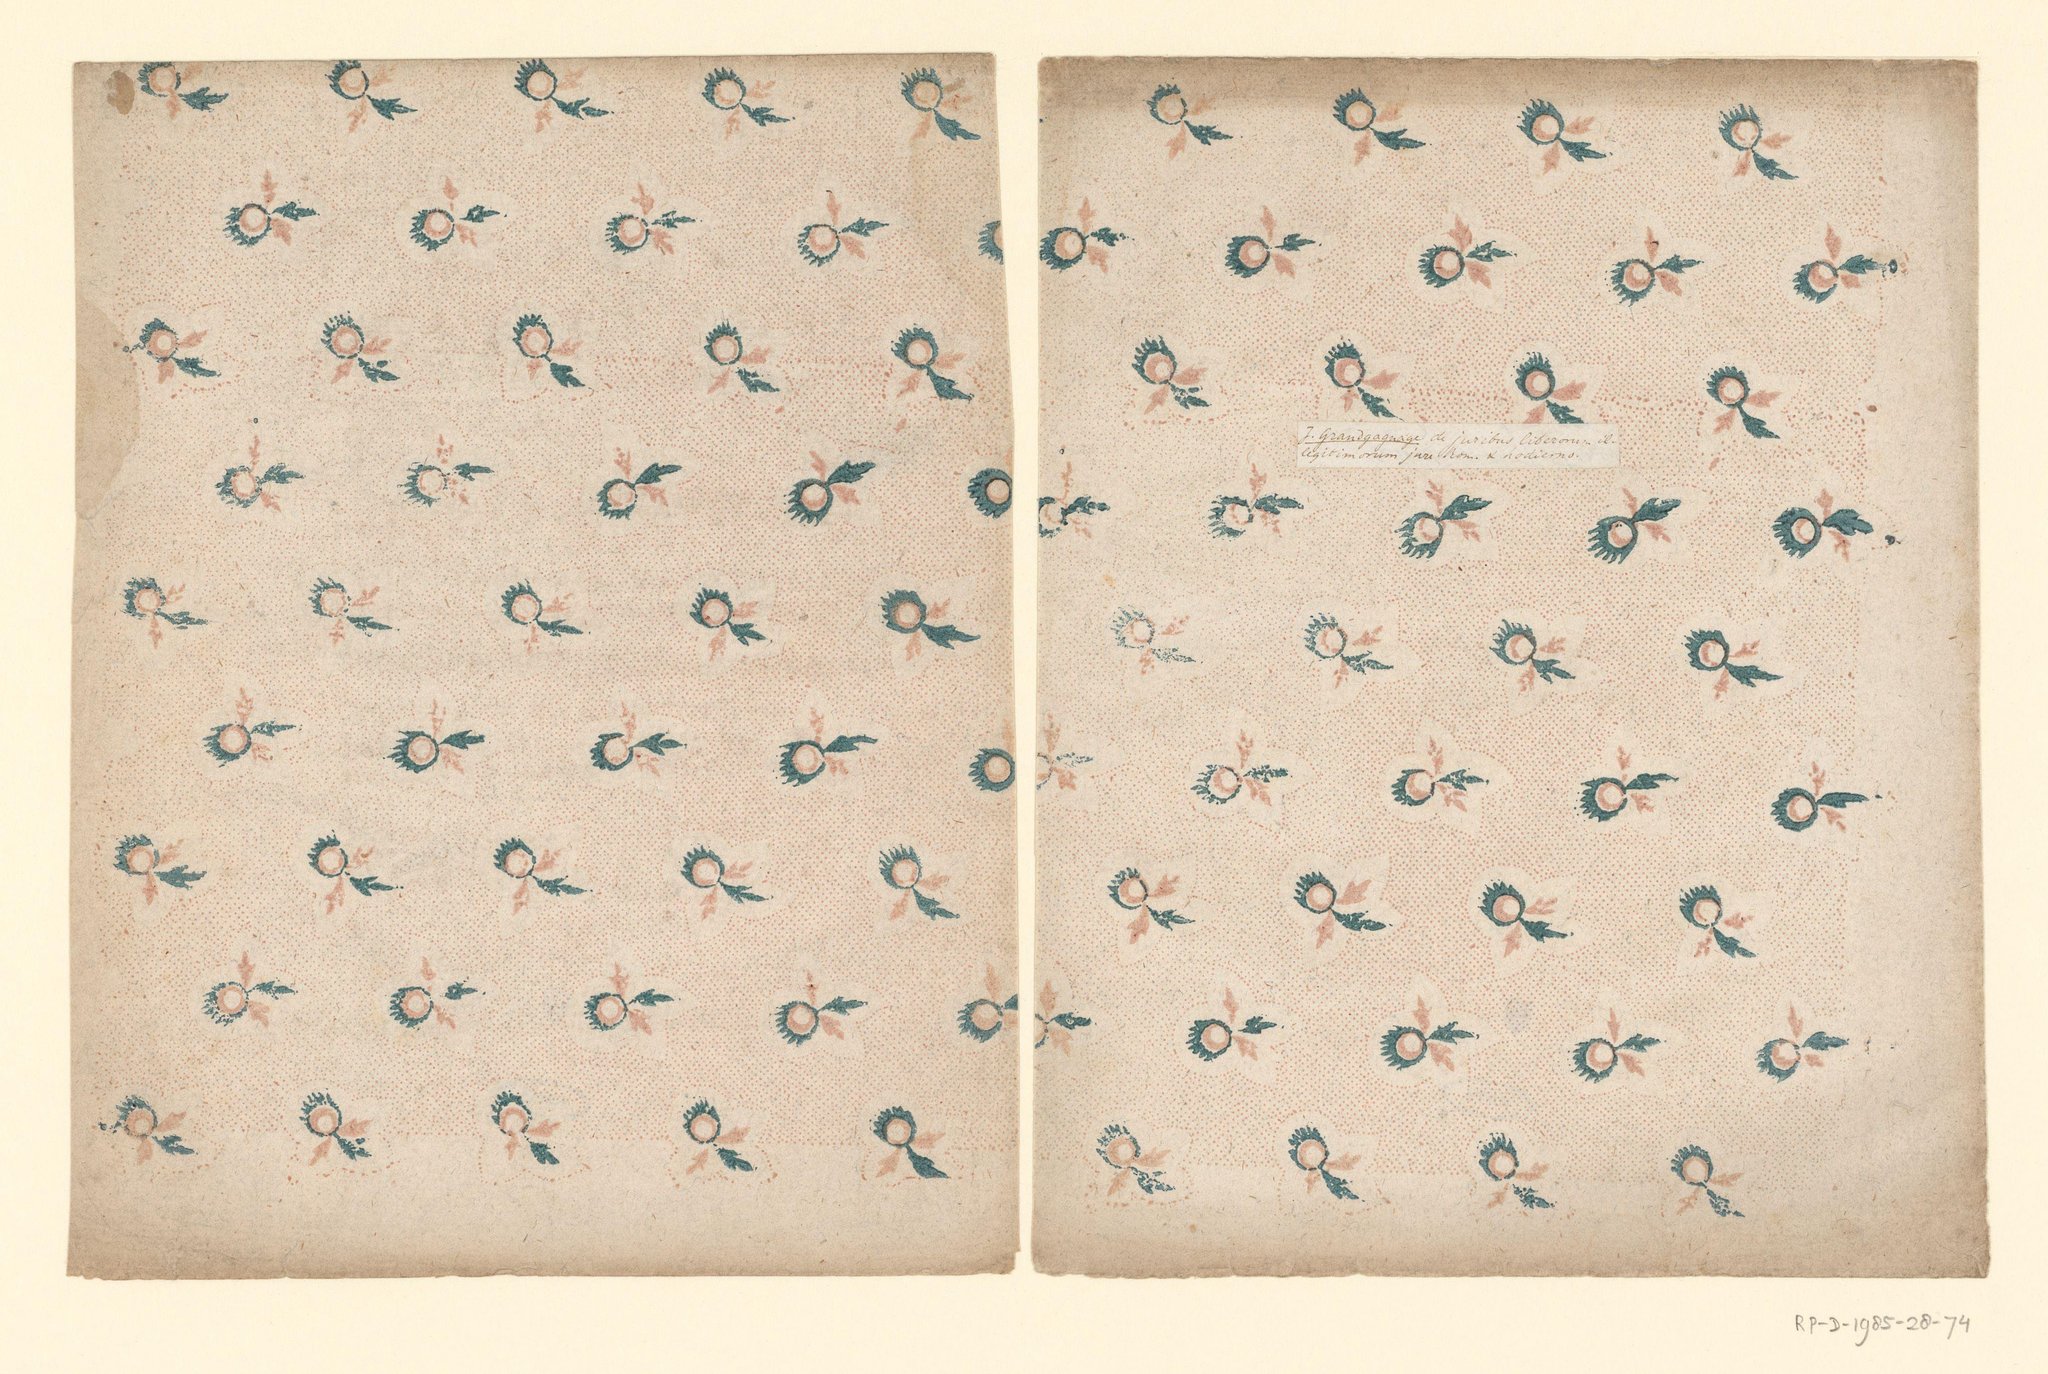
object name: printed paper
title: Twee bladen met strooipatroon van een bloem op puntenfond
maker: Anonymous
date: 1750-1900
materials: paper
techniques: printing block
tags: ornament derived from plant forms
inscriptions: collector's mark: Lugt 2228, collector's mark: Lugt 2760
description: Twee bladen met strooipatroon van een bloem op puntenfond. Met etiket met opschrift: 'J. Grandgagnage ... Lodierno.' Twee losse helften van een omslag.